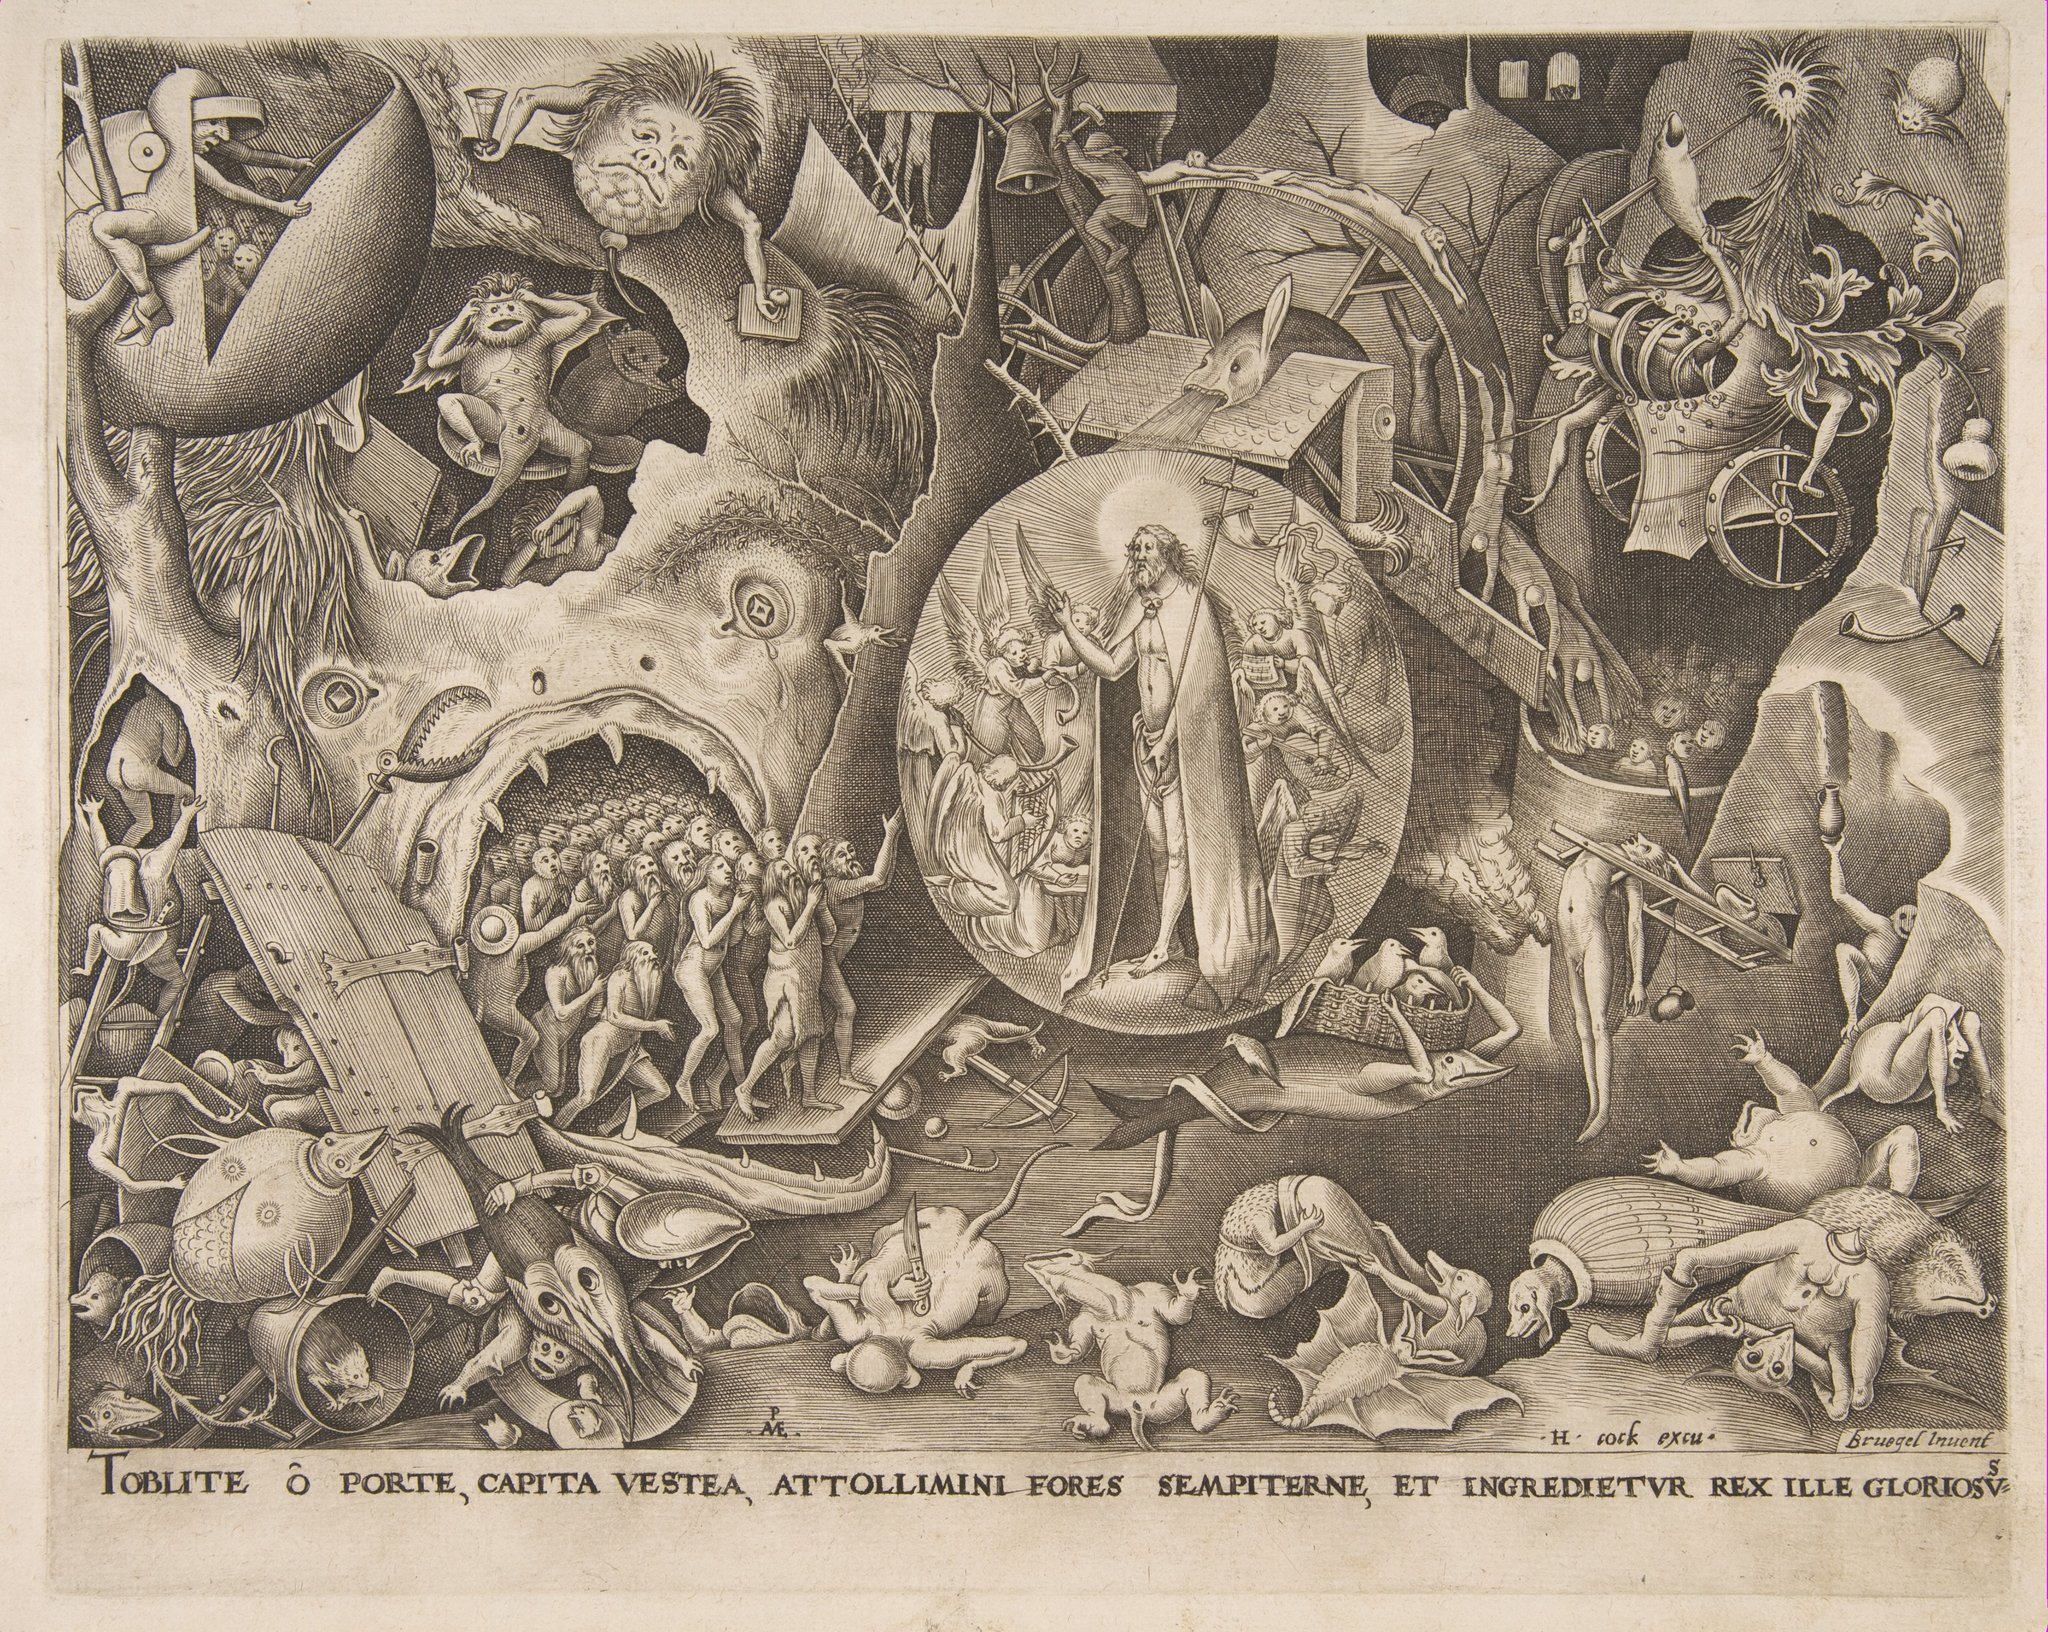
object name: print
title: The Descent of Christ Into Limbo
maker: pieter bruegel the elder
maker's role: artist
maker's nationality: netherlandish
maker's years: 1525-1569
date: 1551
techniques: engraving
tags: angels,christ,cross